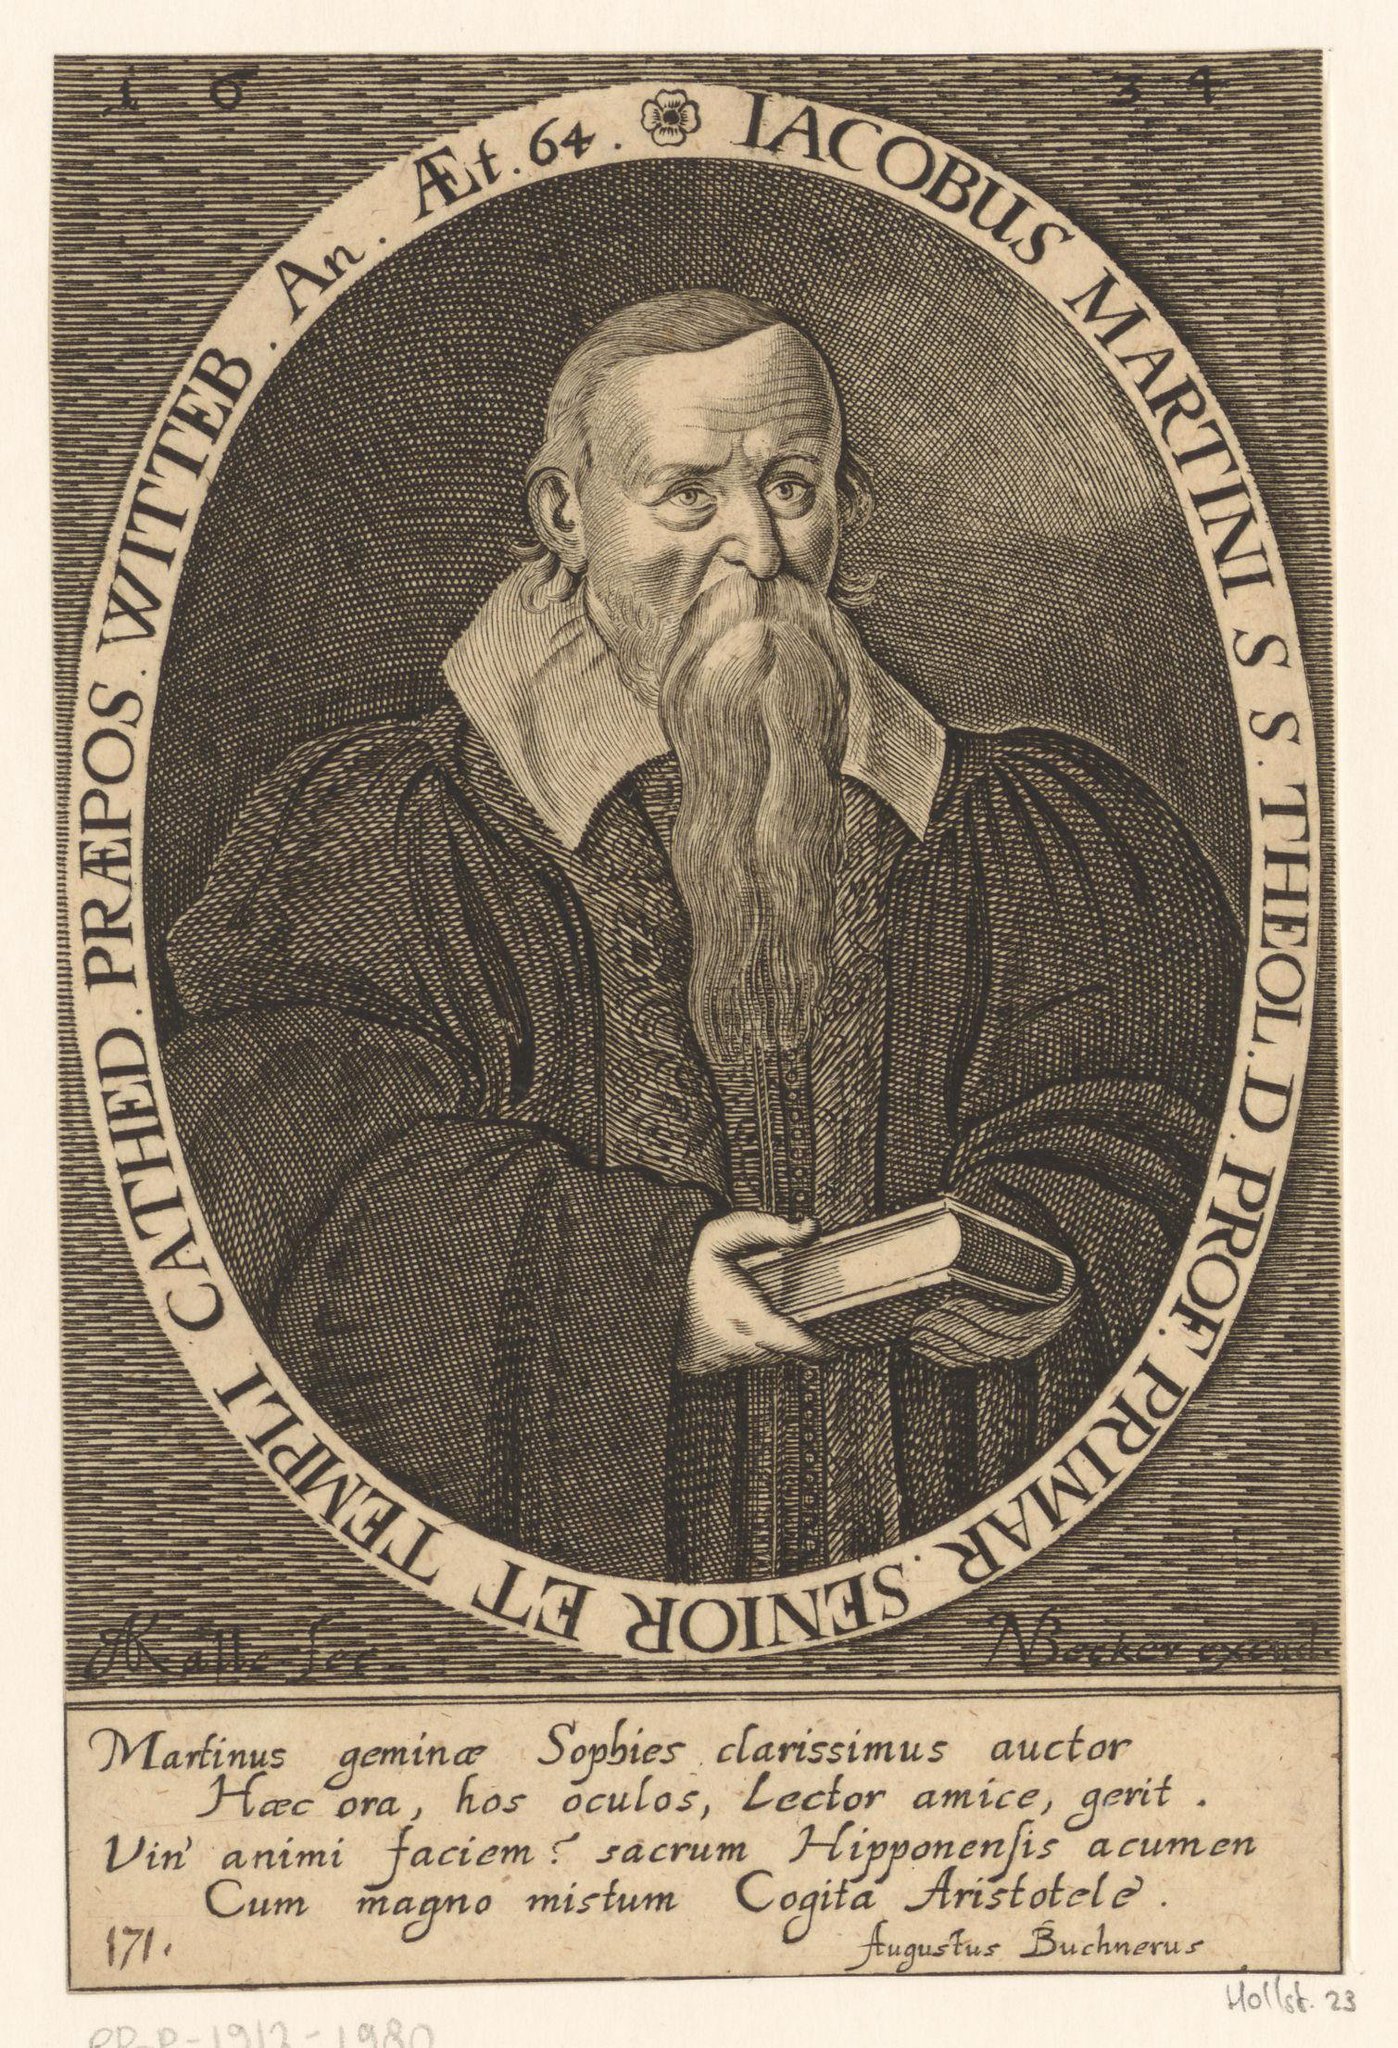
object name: print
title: Portret van Jakob Martini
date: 1634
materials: paper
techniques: engraving, etching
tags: theologian, scholar, philosopher, historical persons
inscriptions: collector's mark: Lugt 2228, number: ‘171.’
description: Tekst in het Latijn in de omlijsting en in de marge.